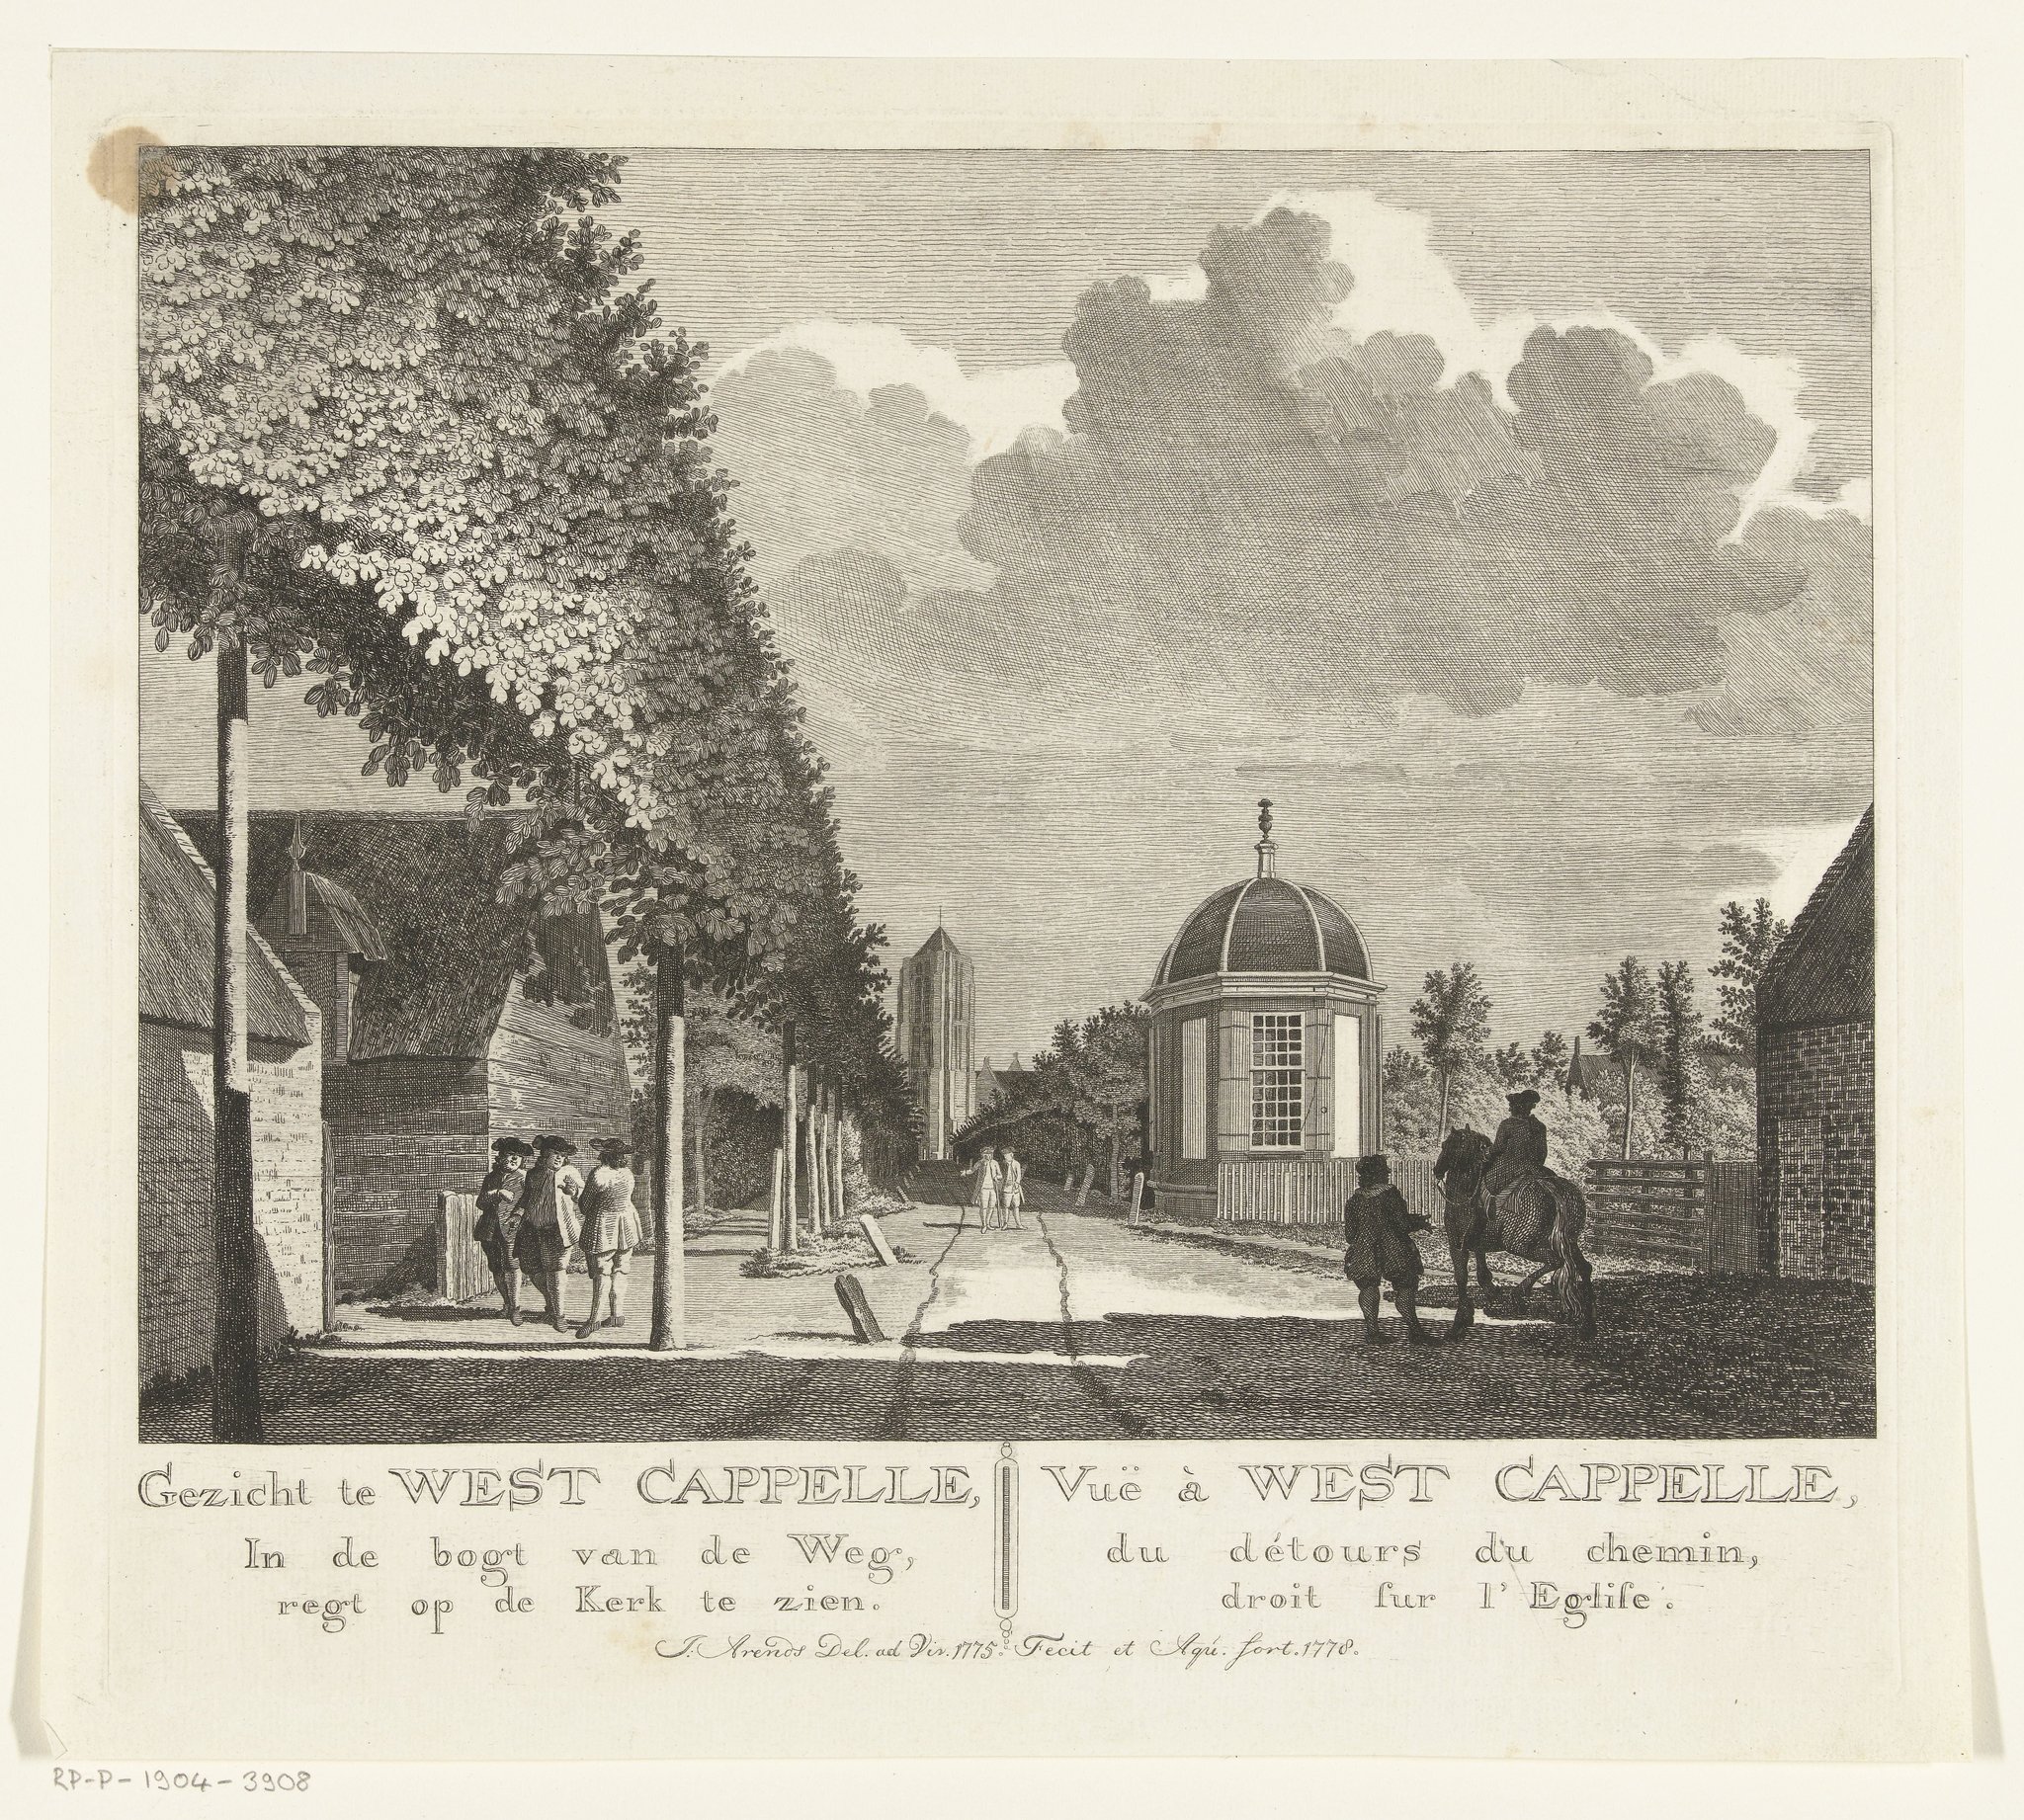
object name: print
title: Gezicht te West Cappelle, in de bogt van de Weg, regt op de Kerk te zien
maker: jan arends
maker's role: draughtsman, print maker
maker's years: 1738-1805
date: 1775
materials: paper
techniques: etching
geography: zeeland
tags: church (exterior), street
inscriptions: collector's mark: Lugt 2228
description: Gezicht op een laan met wandelaars. Op de achtergrond de toren van de kerk van Westkapelle. Met onderschrift in het Nederlands en het Frans.